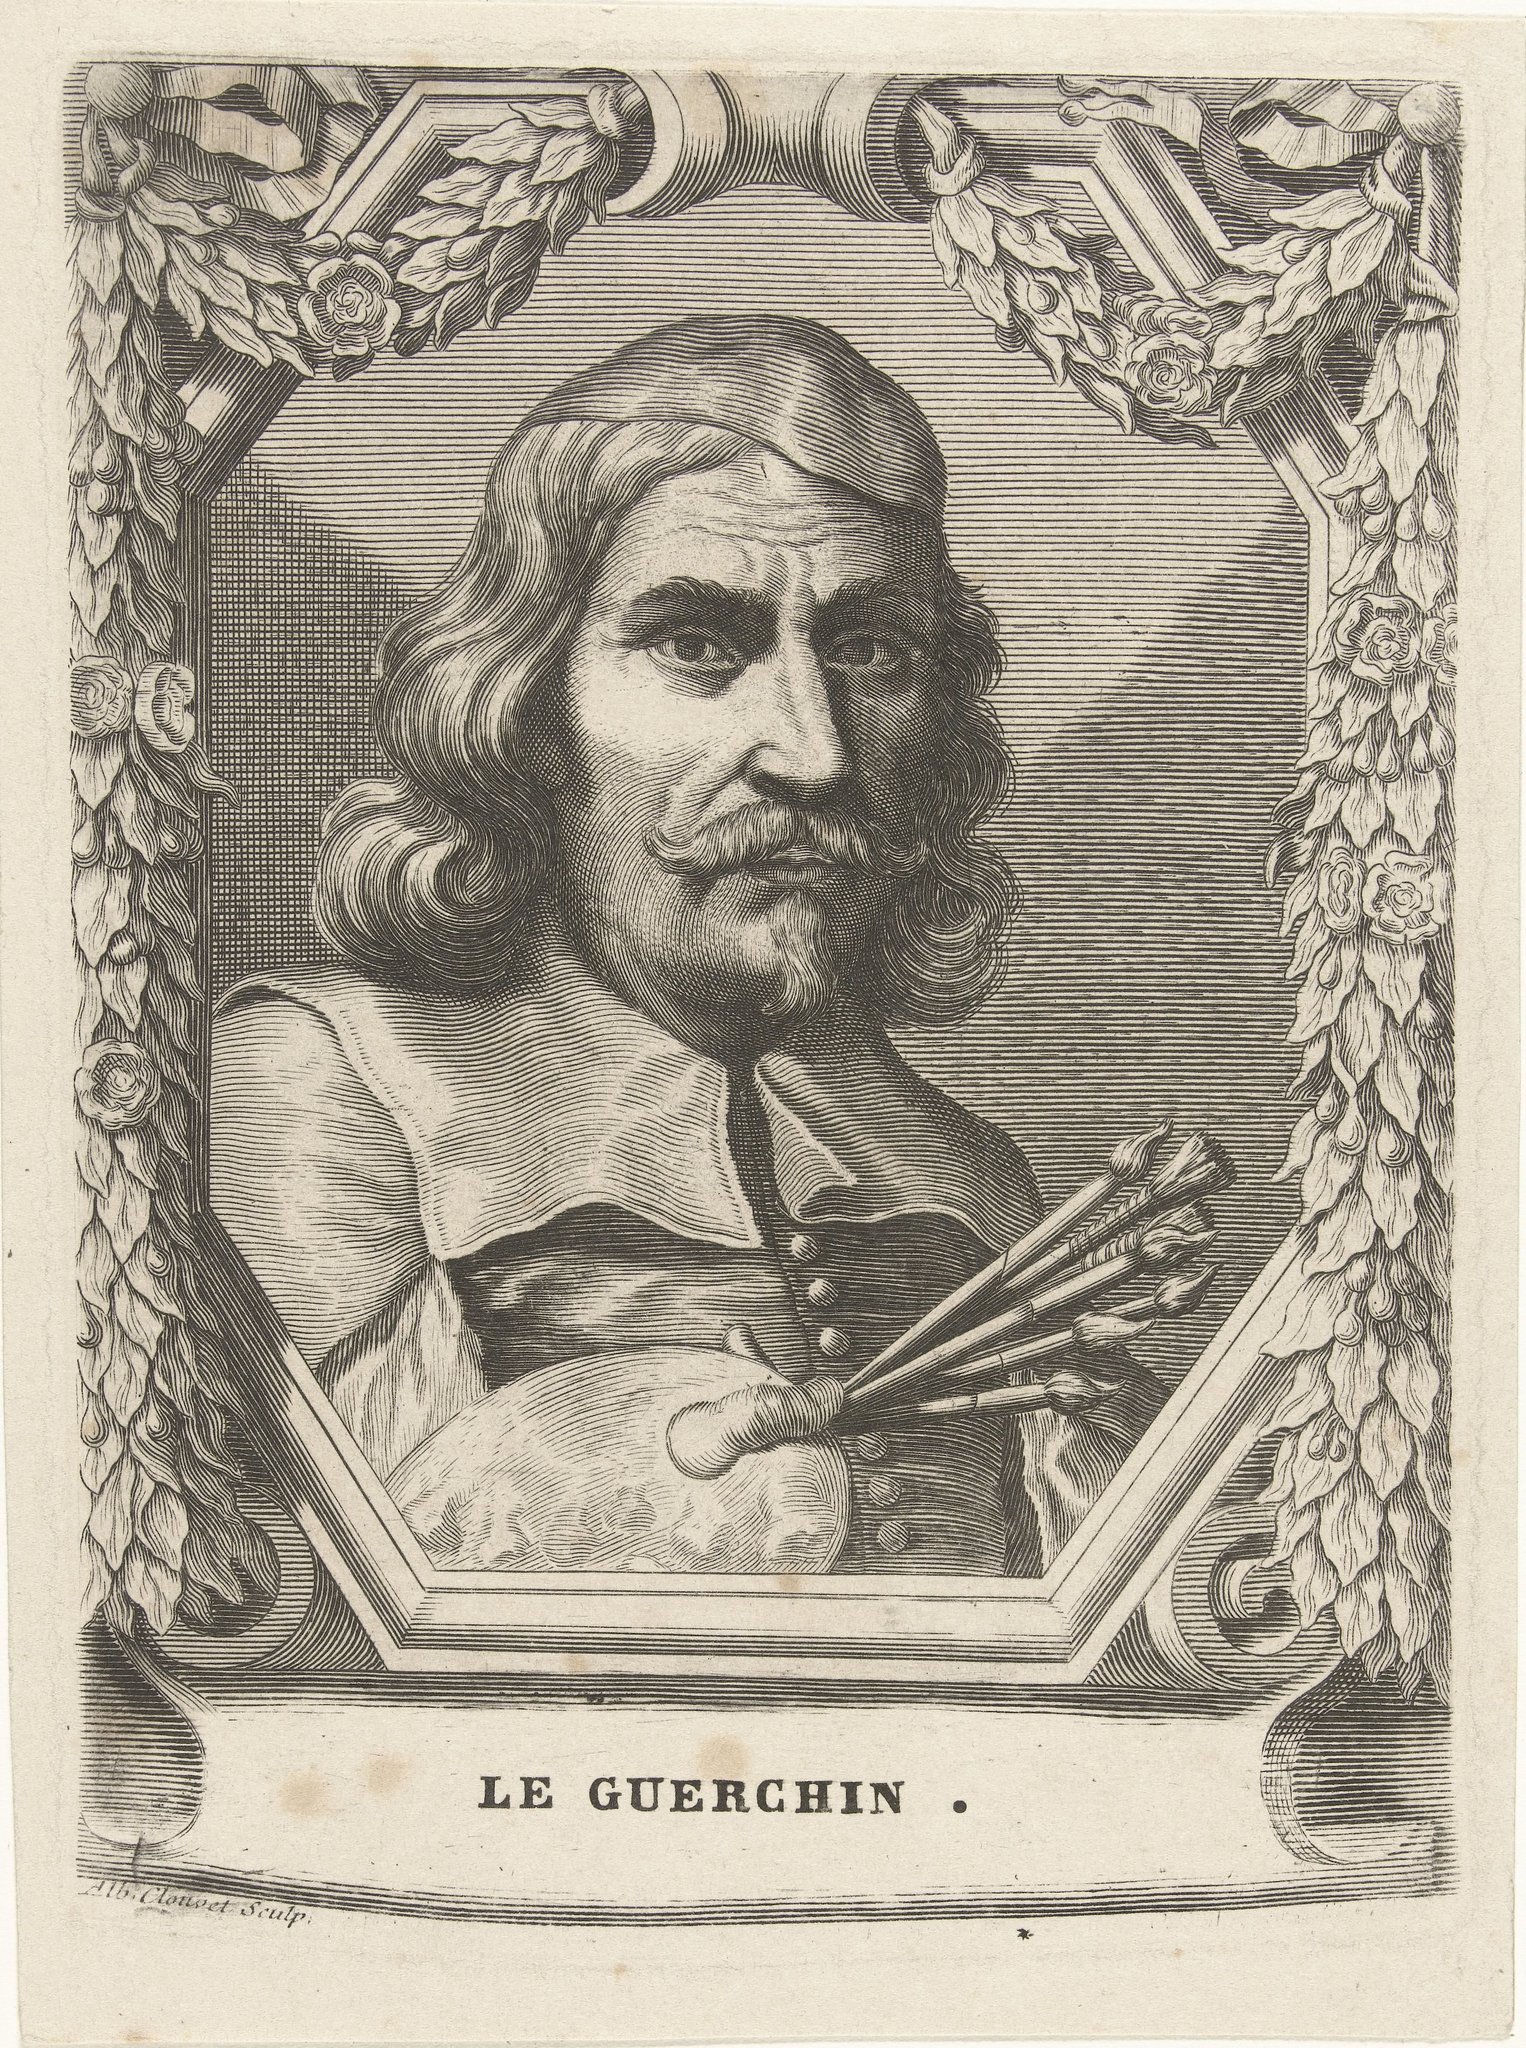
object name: print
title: Portret van Guercino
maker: albertus clouwet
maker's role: print maker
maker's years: 1636-1679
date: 1646-1679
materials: paper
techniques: engraving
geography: rome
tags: painter, draughtsman, guercino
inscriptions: collector's mark: Lugt 2228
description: Octagonaal portret van Giovanni Francesco Barbieri, beter bekend als Guercino, een Italiaanse schilder. Buste naar rechts.